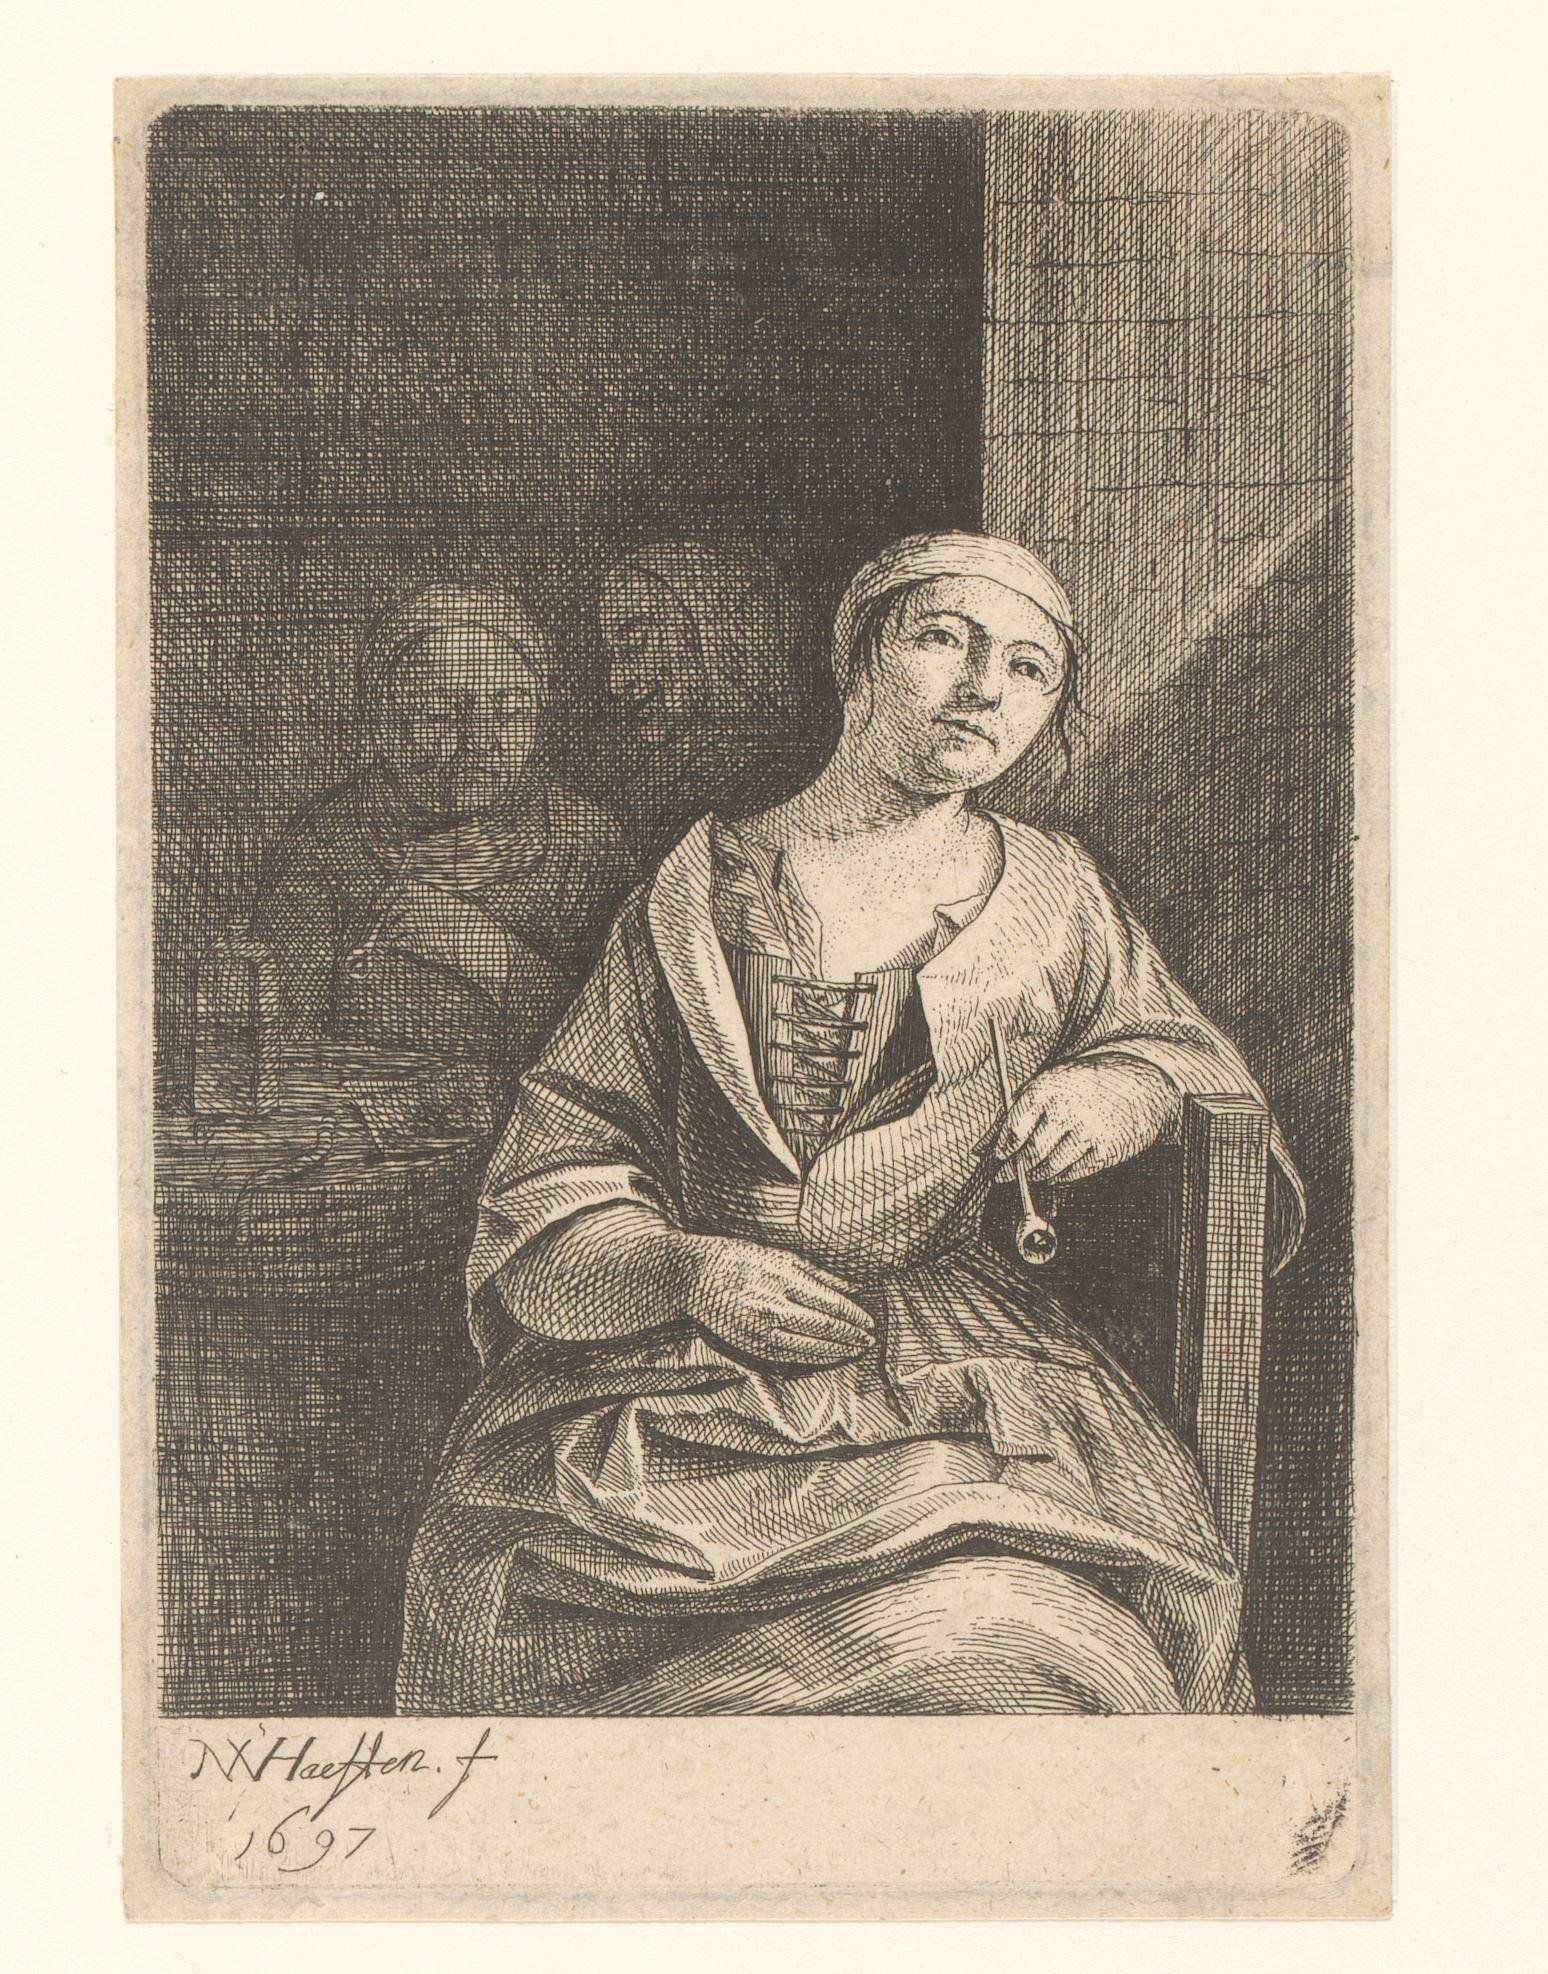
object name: print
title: Zittende rokende vrouw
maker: nicolaes van haeften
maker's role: draughtsman, painter, print maker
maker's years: 1653-1715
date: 1697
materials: paper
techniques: etching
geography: paris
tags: pipe ~ tobacco (+ taking (particular) foodstuffs: eating, drinking, smoking, chewing, etc.)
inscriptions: collector's mark: Lugt 654